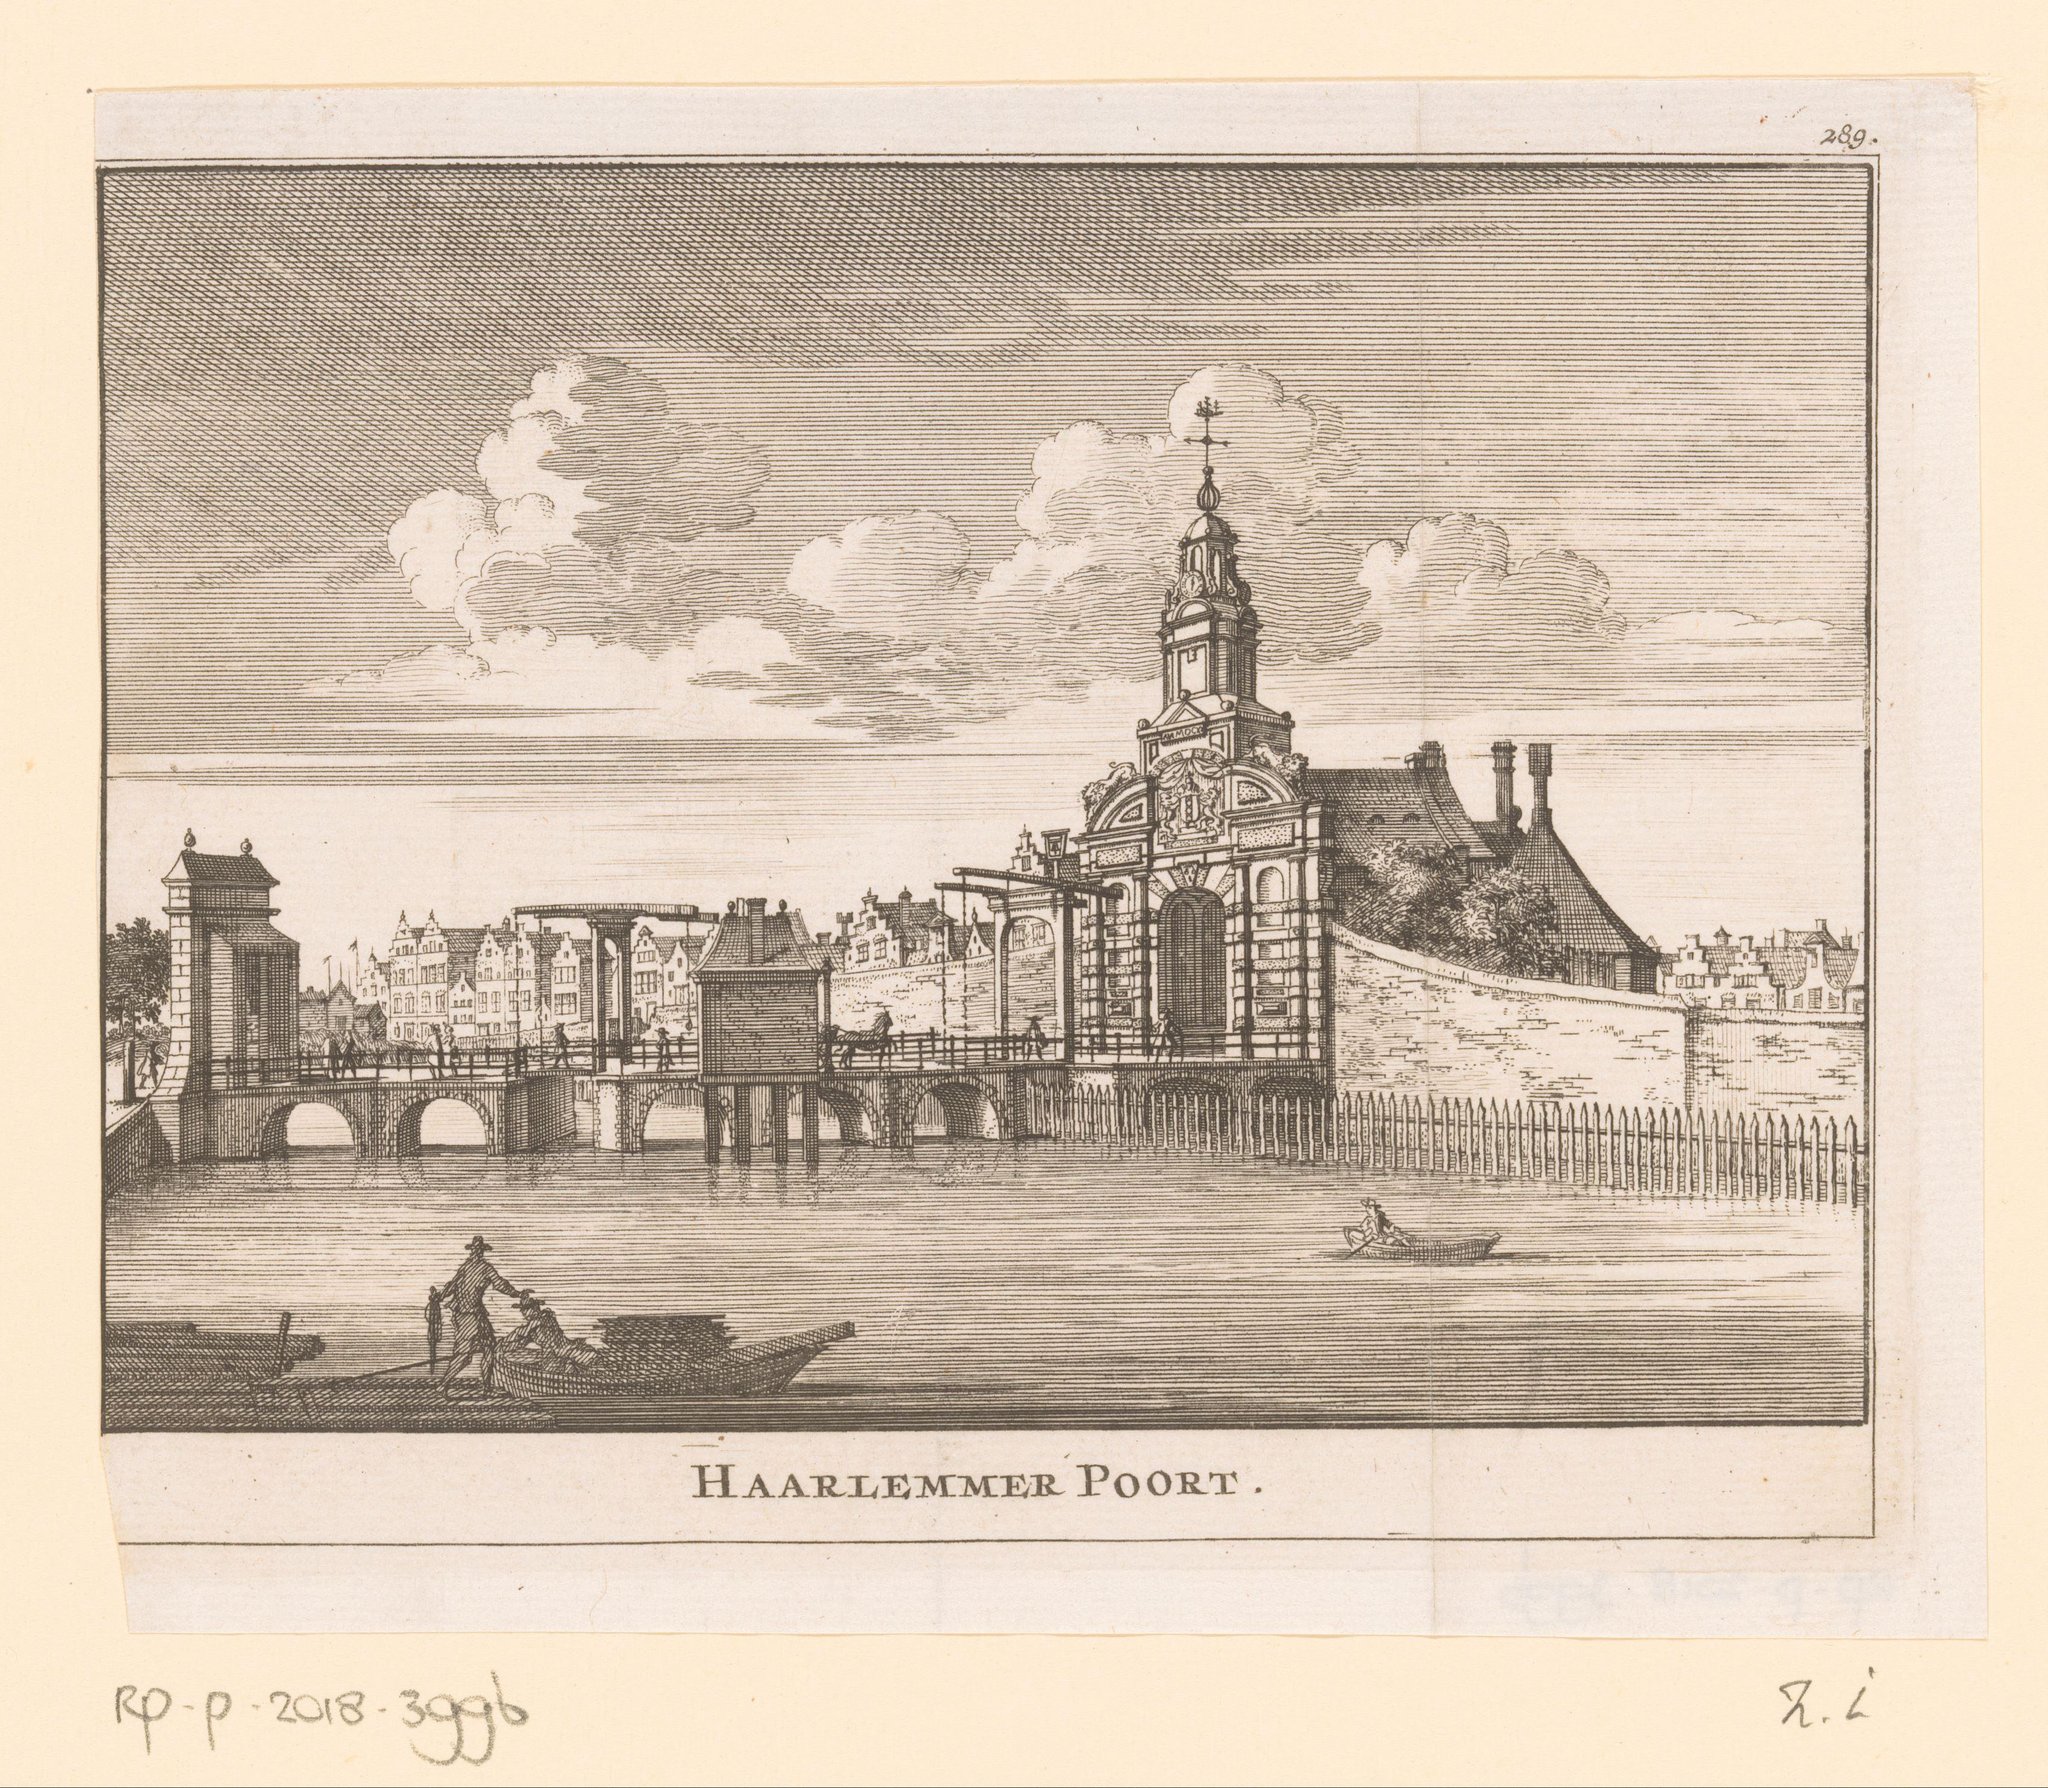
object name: book illustration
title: Haarlemmer poort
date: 1726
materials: paper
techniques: engraving, etching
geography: amsterdam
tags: rowing-boat, canoe, etc., bridge in city across river, canal, etc., city-gate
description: Prent uit: Hoorn, Nicolaas ten. Wegwyzer door Amsterdam, Zynde eene beknopte verhandeling van desselfs eerste opkomst, vergrootingen, en teegenwoordigen staat (…). Tweede druk. Amsterdam: Nicolaas ten Hoorn, 1726, p. 288-289. En in de latere edities (Amsterdam: erven J. Ratelband & Co, 1737, en Amsterdam: Pieter Meyer, 1751). In de eerste editie heeft deze prent een andere plek in het boek, en een ander nummer.